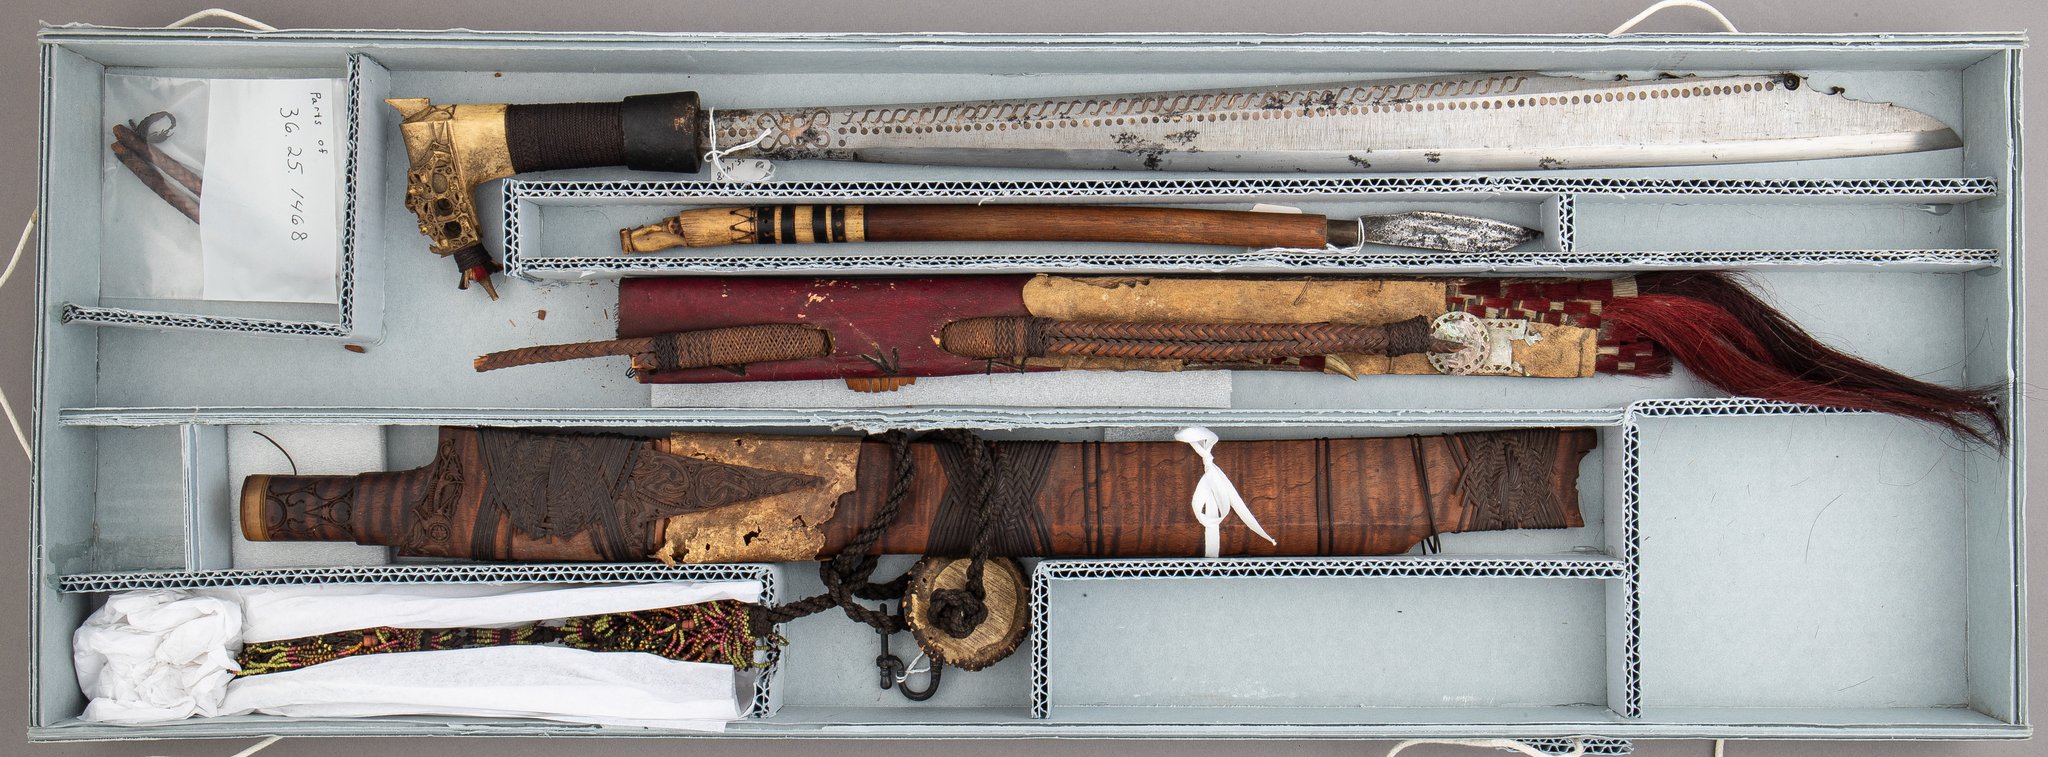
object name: sword mandau with scabbard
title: Sword (Mandau) with Scabbard and Small Knife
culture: dyak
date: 1701-1900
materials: horn, rattan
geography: borneo